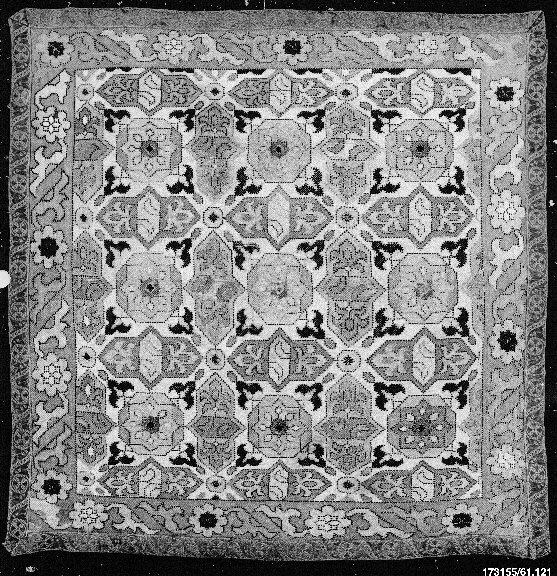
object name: textile fragment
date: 1701-1800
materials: linen, metal thread, silk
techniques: embroidery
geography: iran